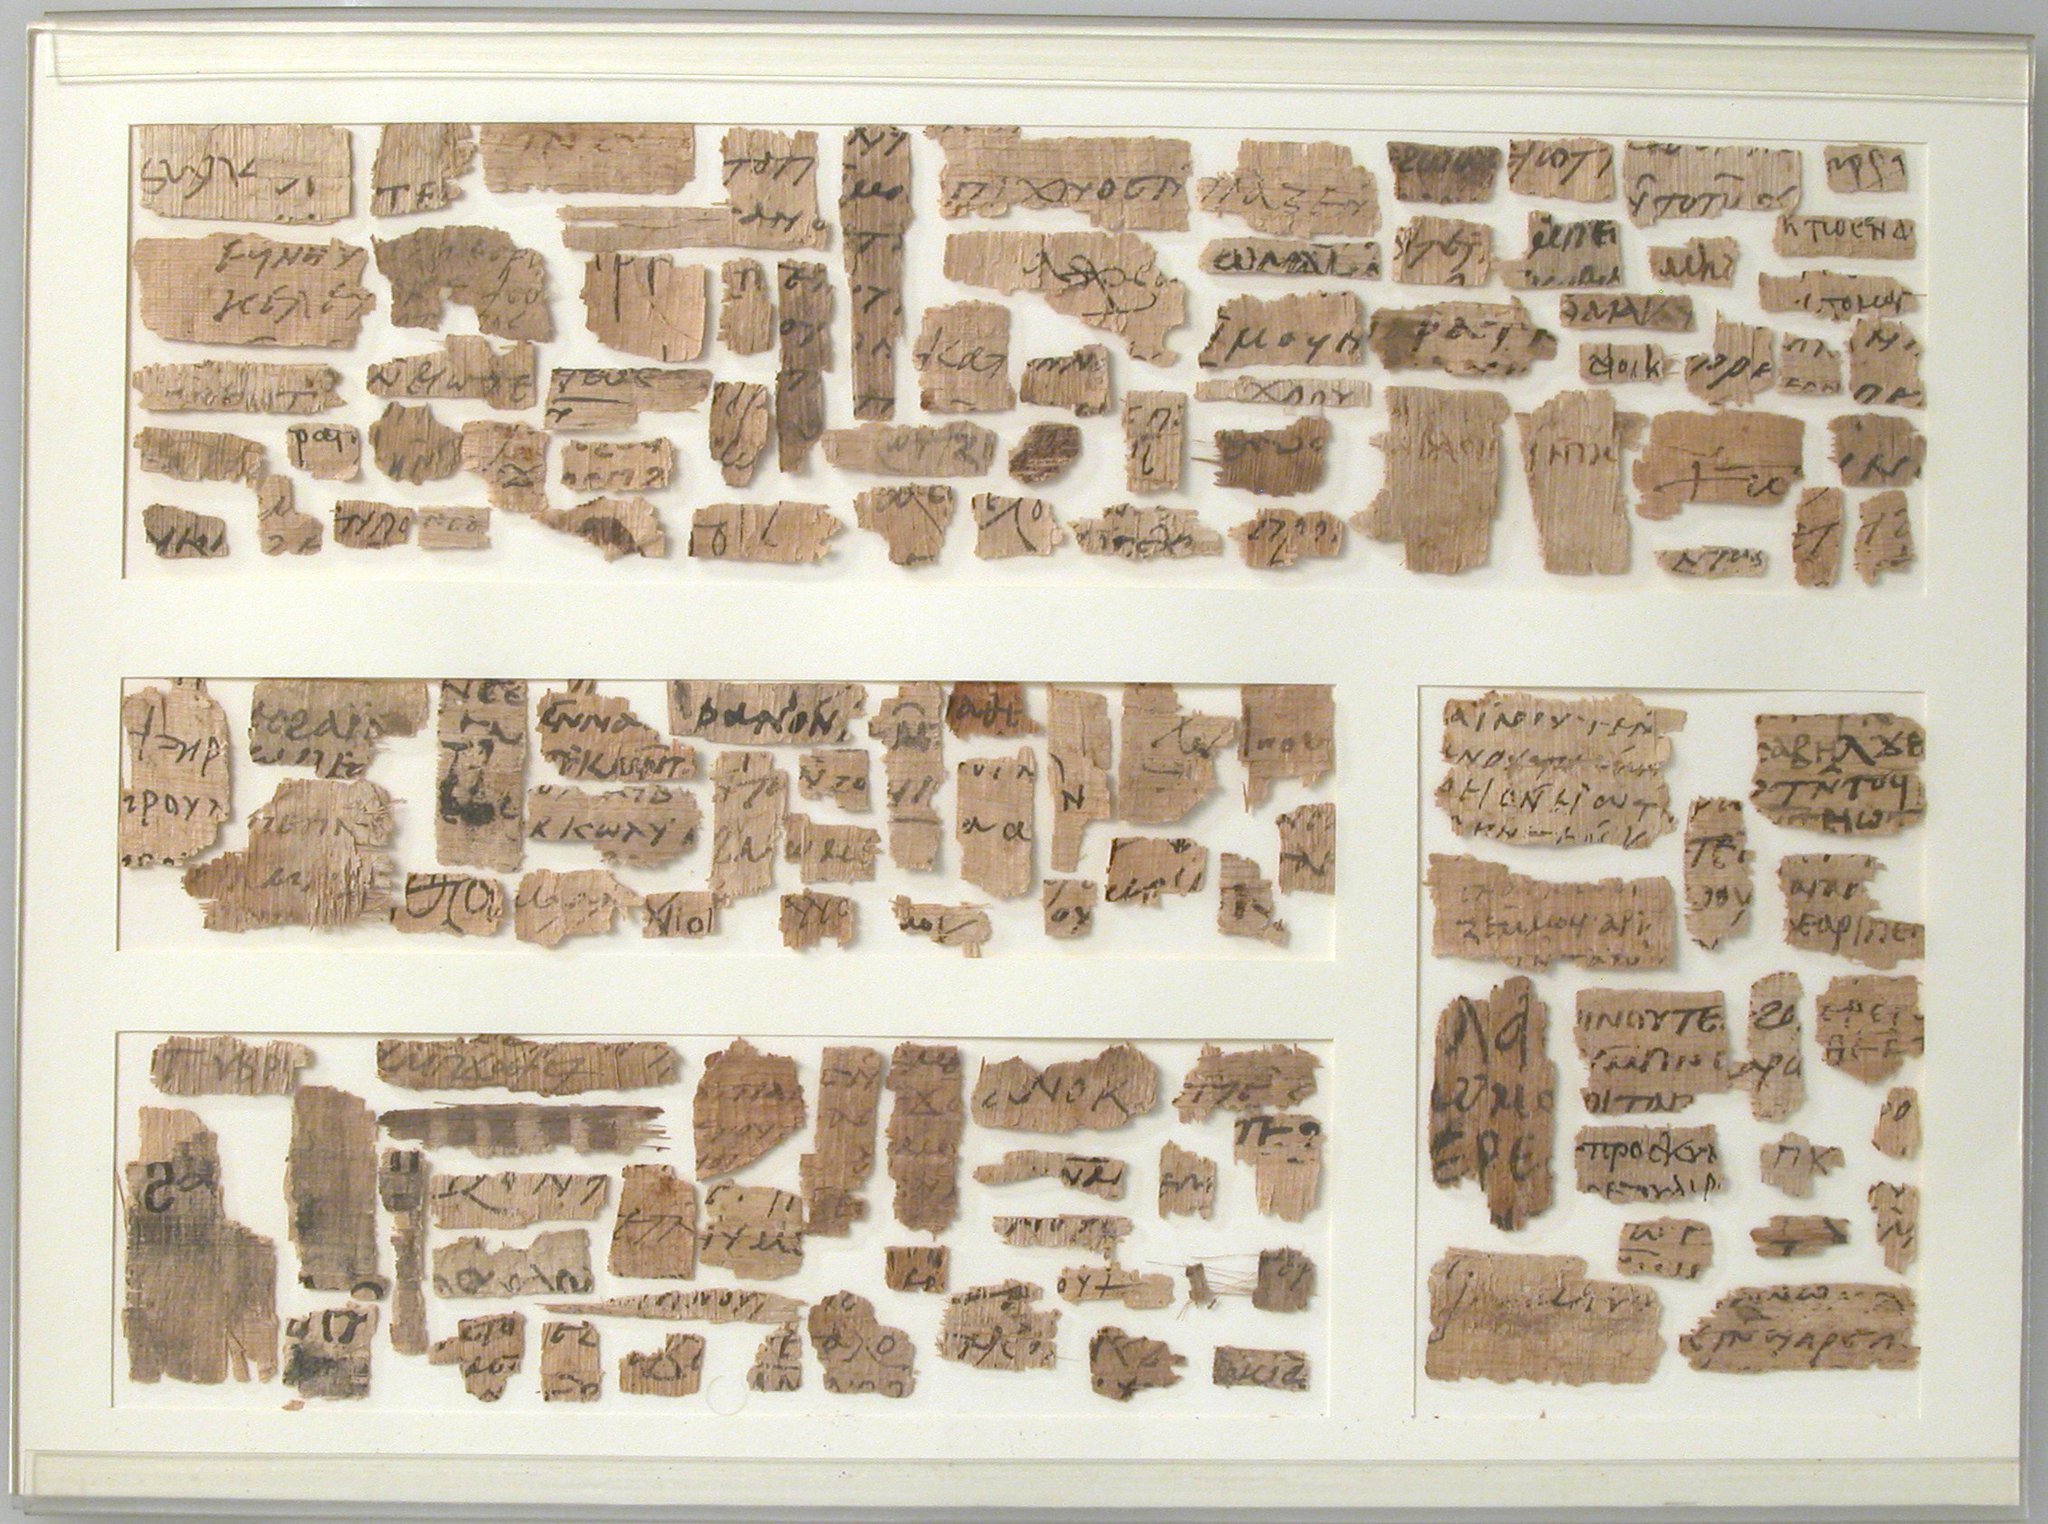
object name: fragment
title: Papyri Fragments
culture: coptic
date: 601-700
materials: ink, papyrus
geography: egypt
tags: documents